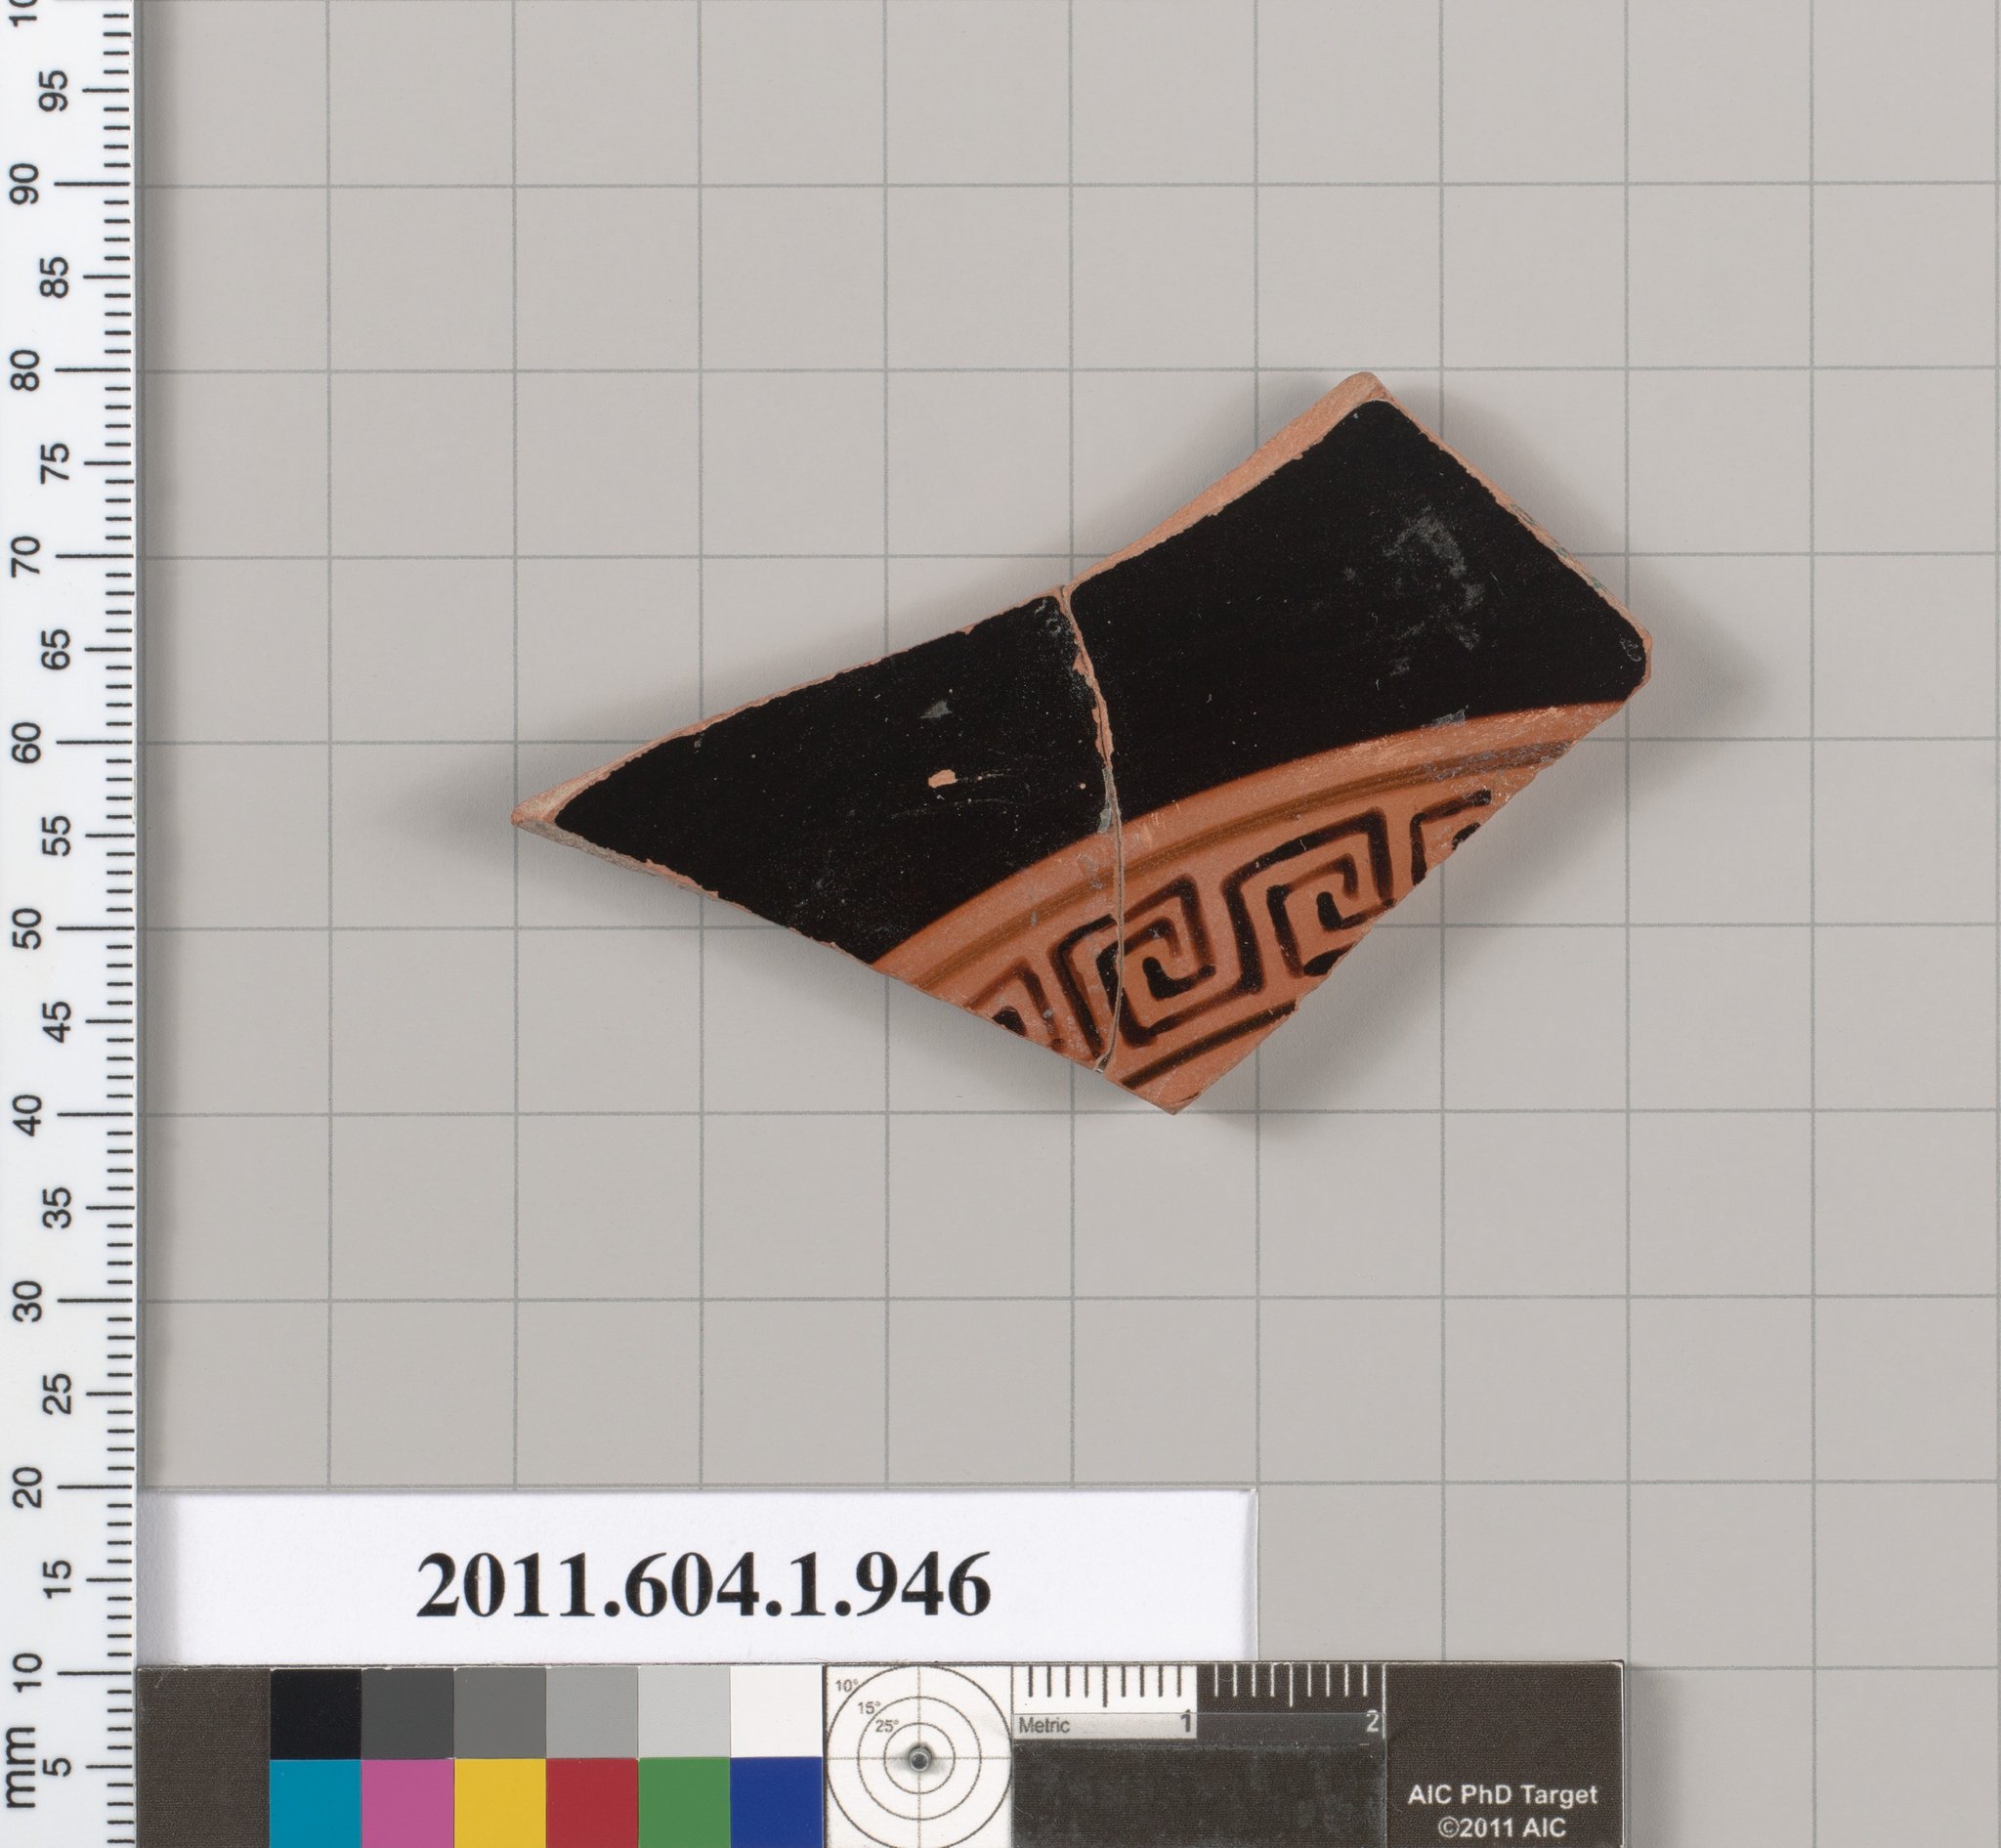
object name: kylix fragment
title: Terracotta fragment of a kylix (drinking cup)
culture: greek, attic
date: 490-480 BCE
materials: terracotta